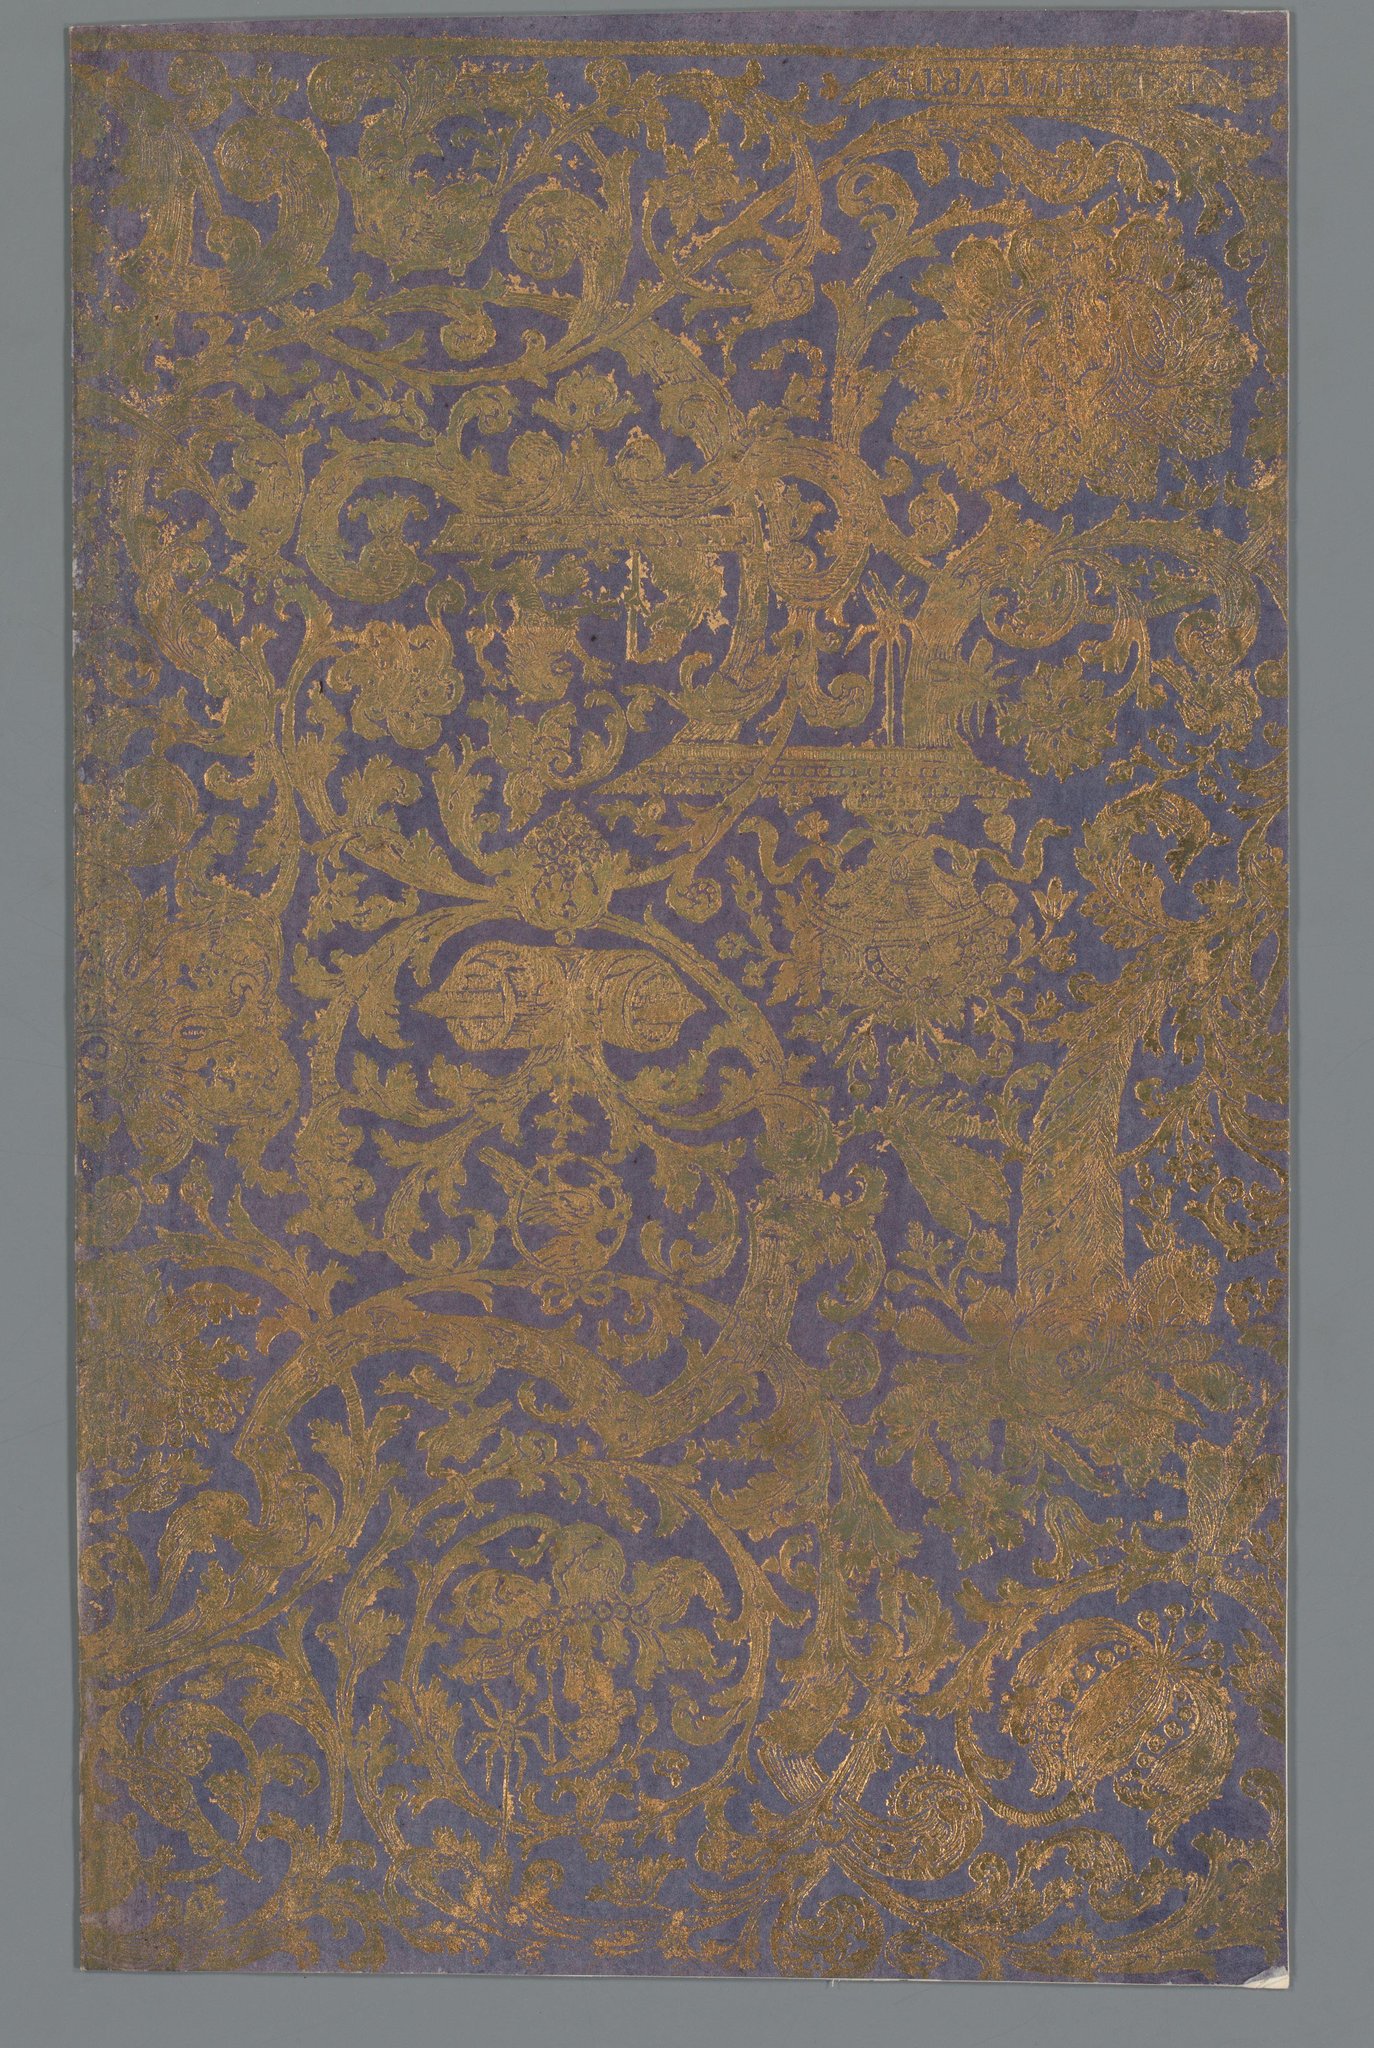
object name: pamphlet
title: Boekje met omslag van brokaatpapier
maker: georg popp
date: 1710-1735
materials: gold leaf, paint, paper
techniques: relief print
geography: furth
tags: ornament derived from animal forms, ornament derived from plant forms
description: Pamflet met een omslag van een blad brokaatpapier met gestileerde bloemen, links hoorn des overvloeds en vruchtenschaal met spin en heraldische leeuw, rechts grote bloem en granaatappels. Het pamflet bestaat uit drie bladen en is waarschijnlijk gedrukt in Würzburg in 1726.